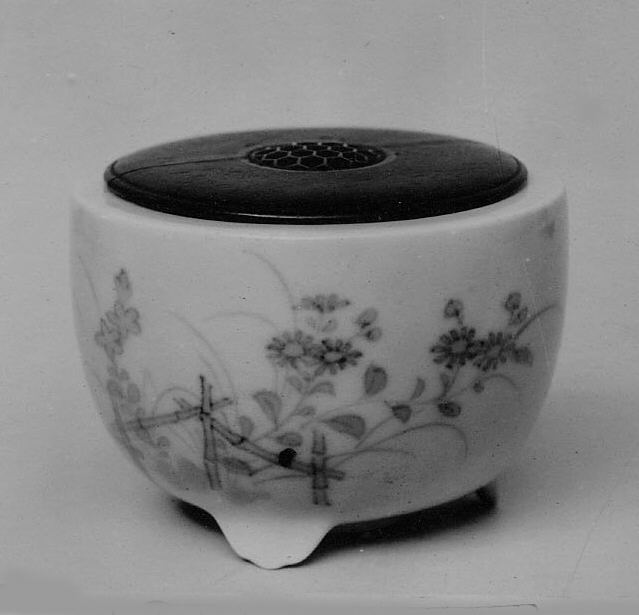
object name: covered censer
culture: japanese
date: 1820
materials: glaze, porcelain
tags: leaves,censers